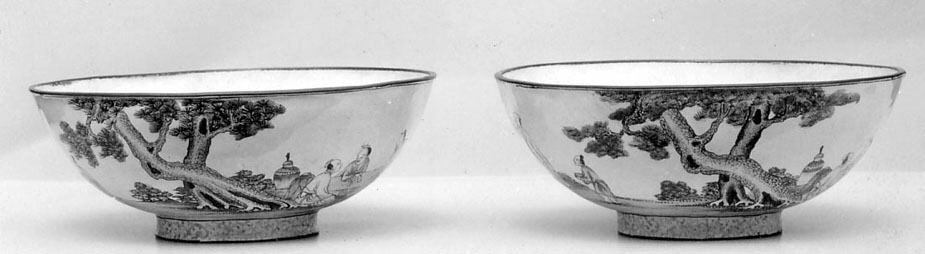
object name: bowl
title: Bowl (one of a pair)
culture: chinese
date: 1801-1900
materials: enamel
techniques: painting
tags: trees